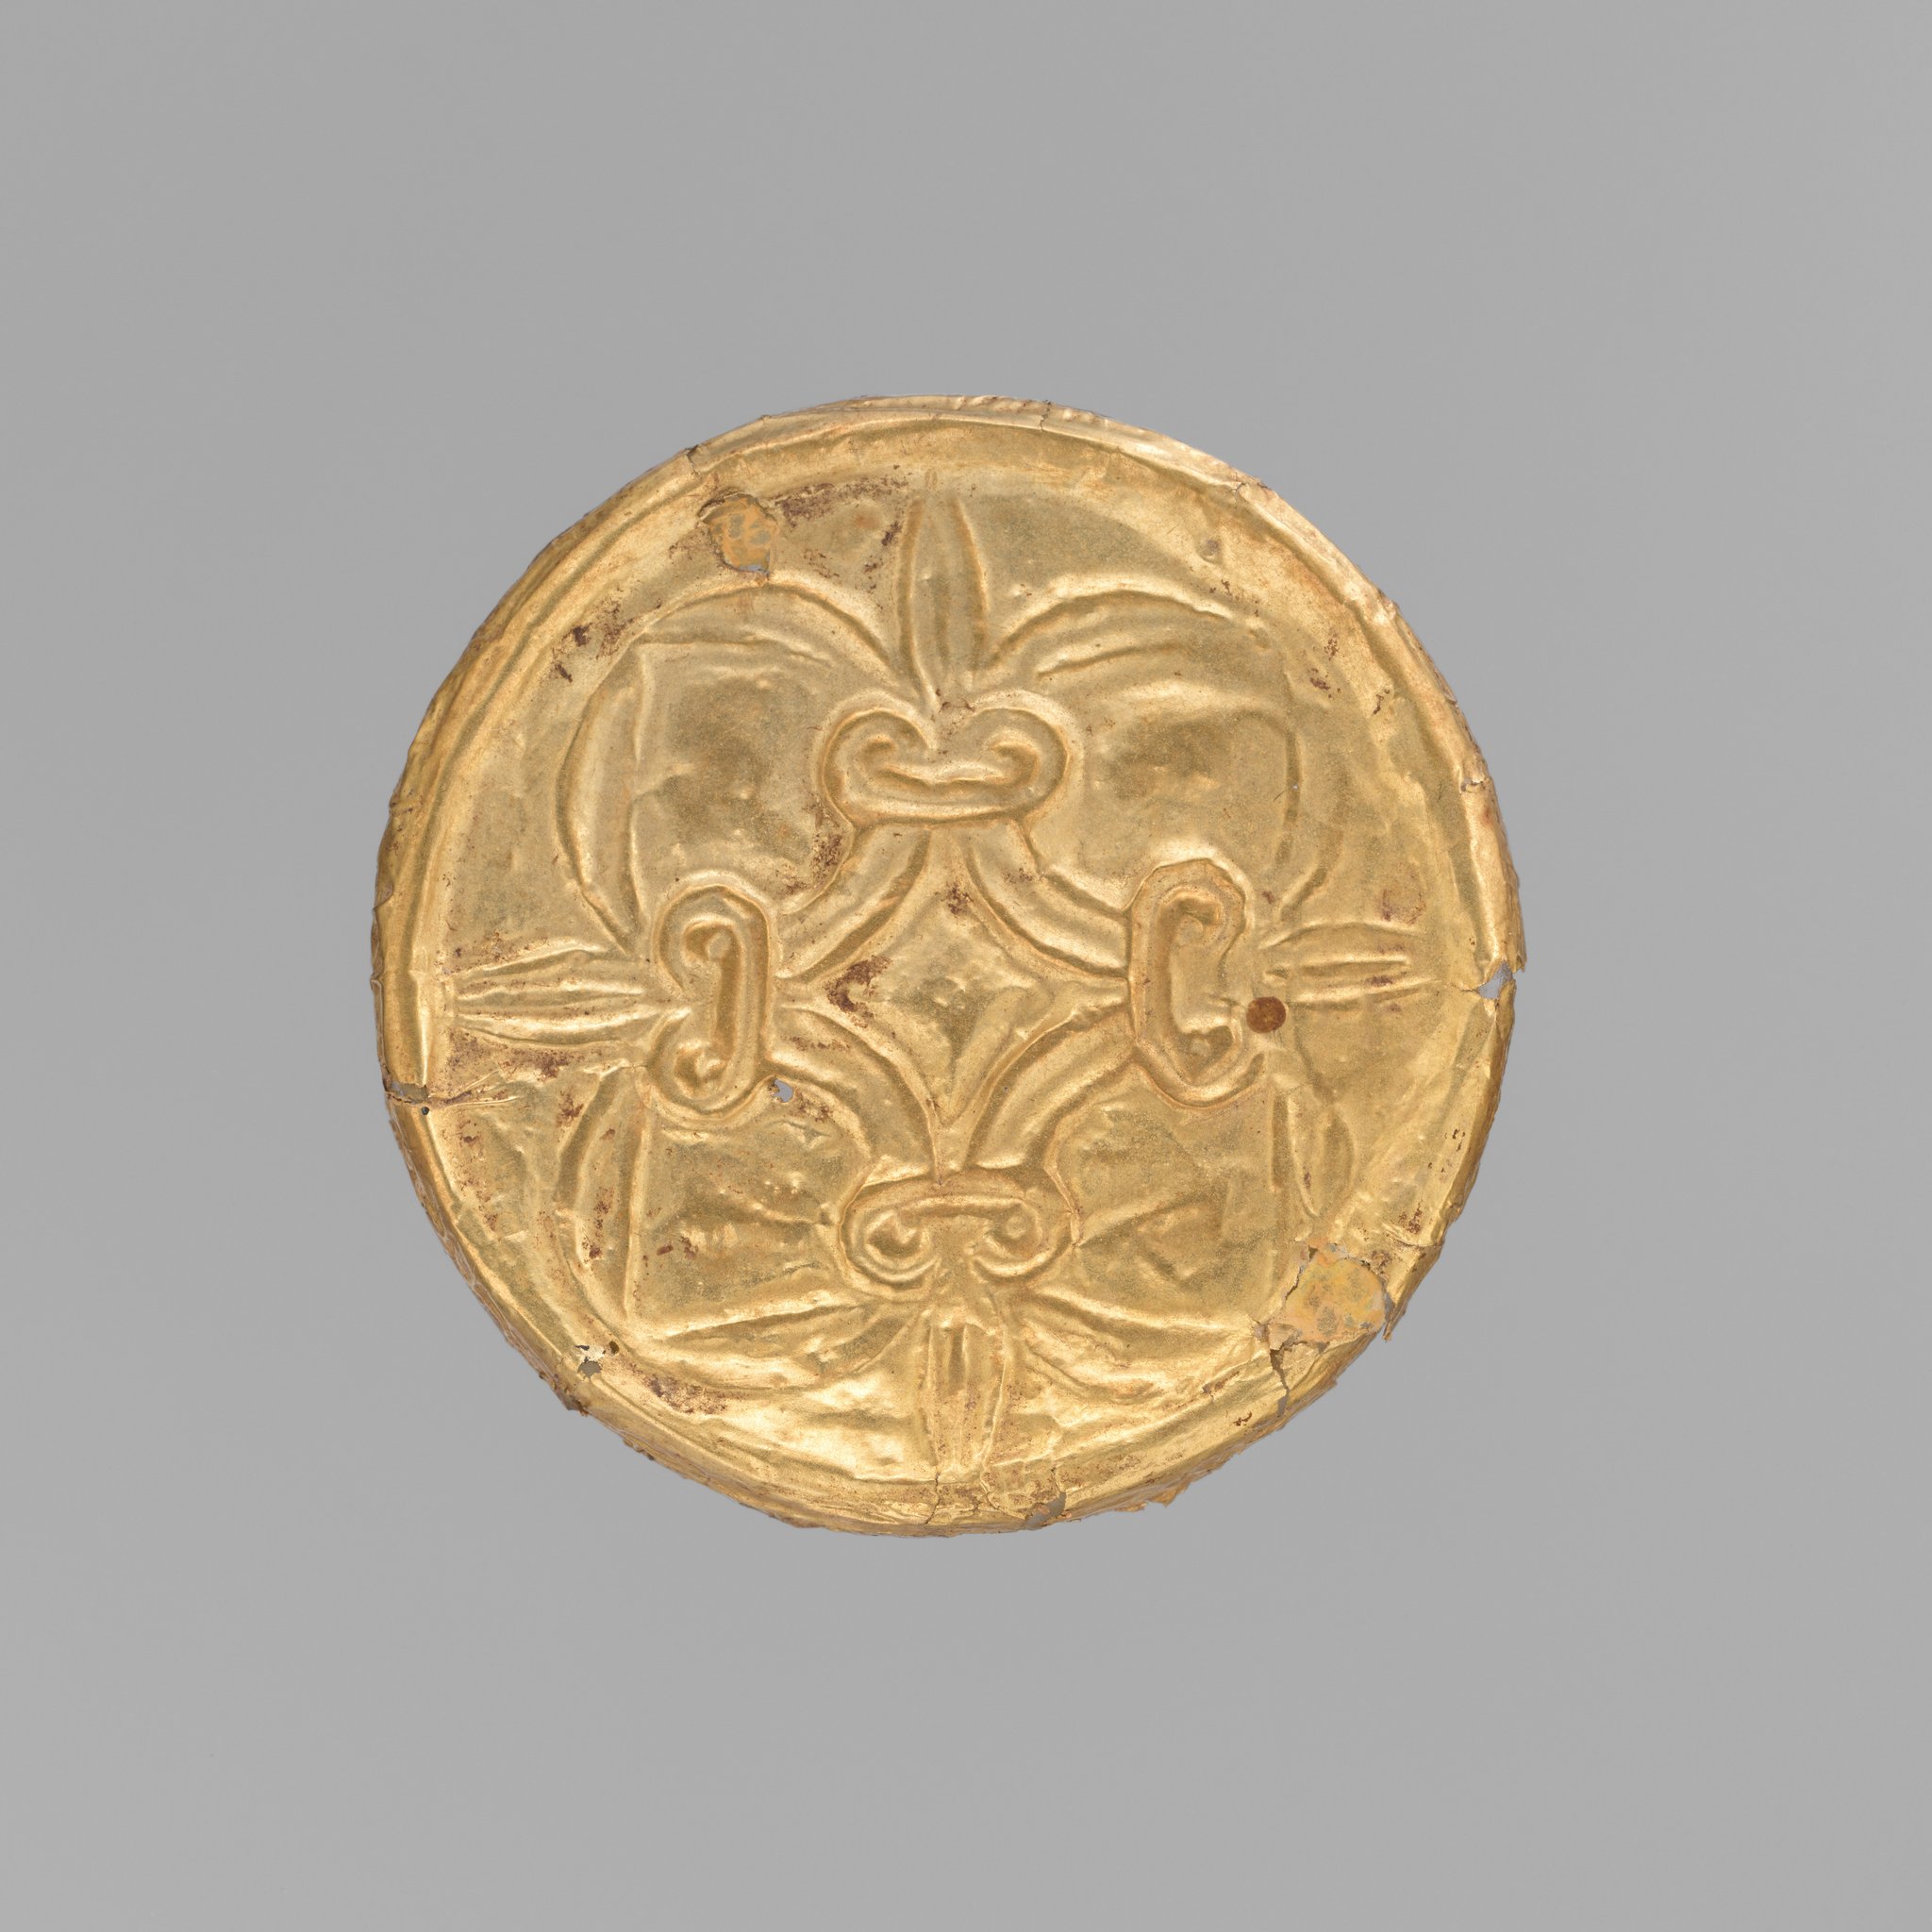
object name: roundel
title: Gold roundel with stamped designs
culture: cypriot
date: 1600-1050 BCE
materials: gold